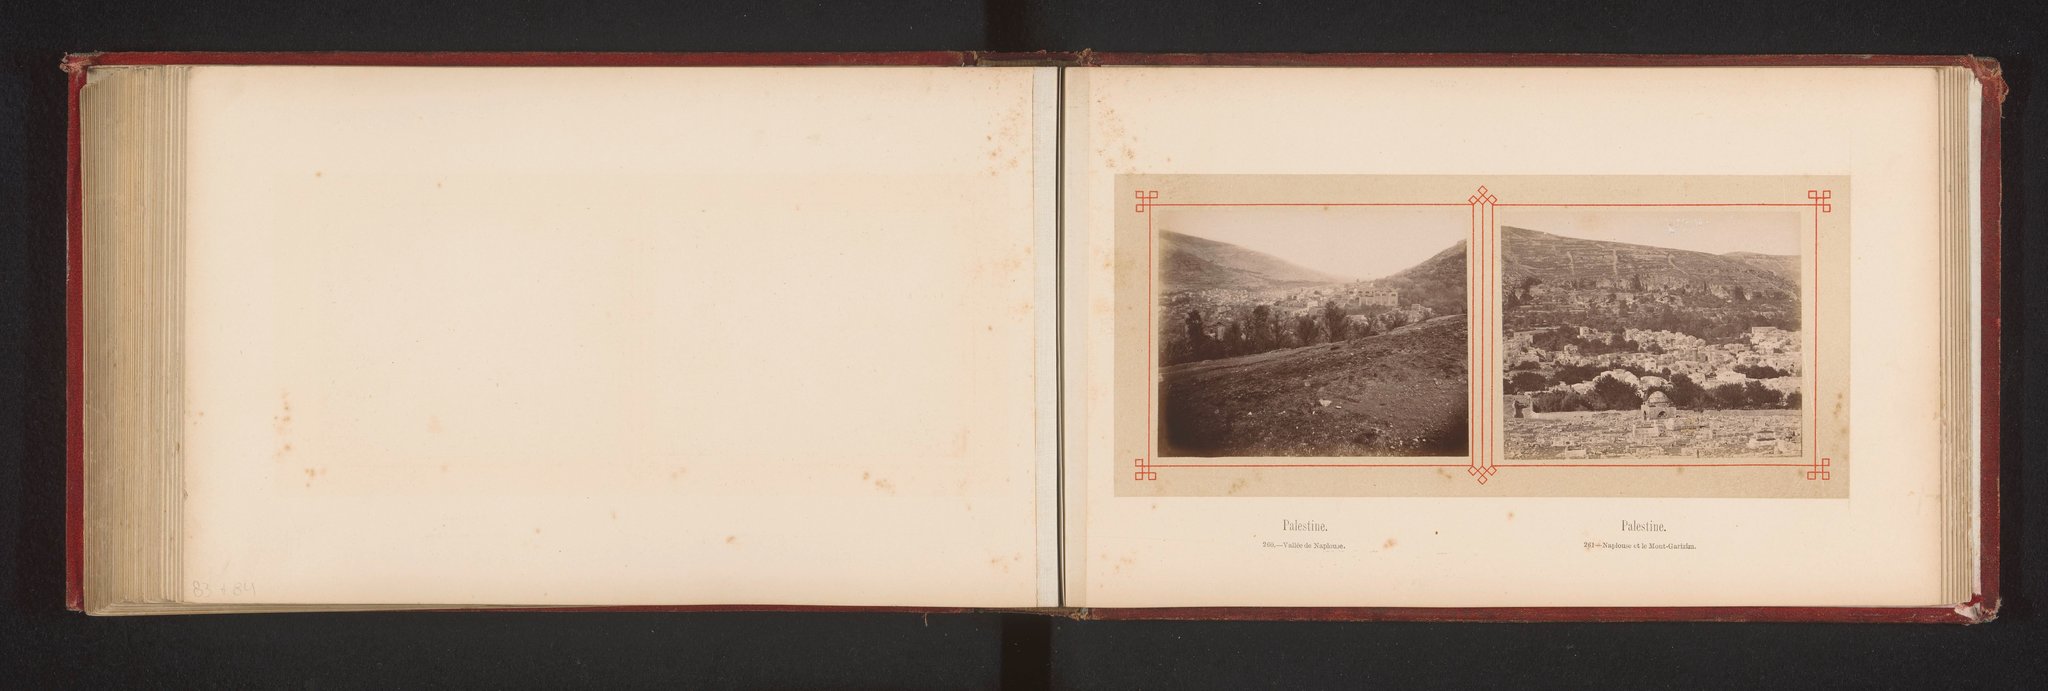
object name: photograph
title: Gezicht op Nablus en Gerizim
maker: félix bonfils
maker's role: fotograaf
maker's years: 1831-1885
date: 1873-1878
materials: photographic support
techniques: albumen print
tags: city-view in general; 'veduta', mountains